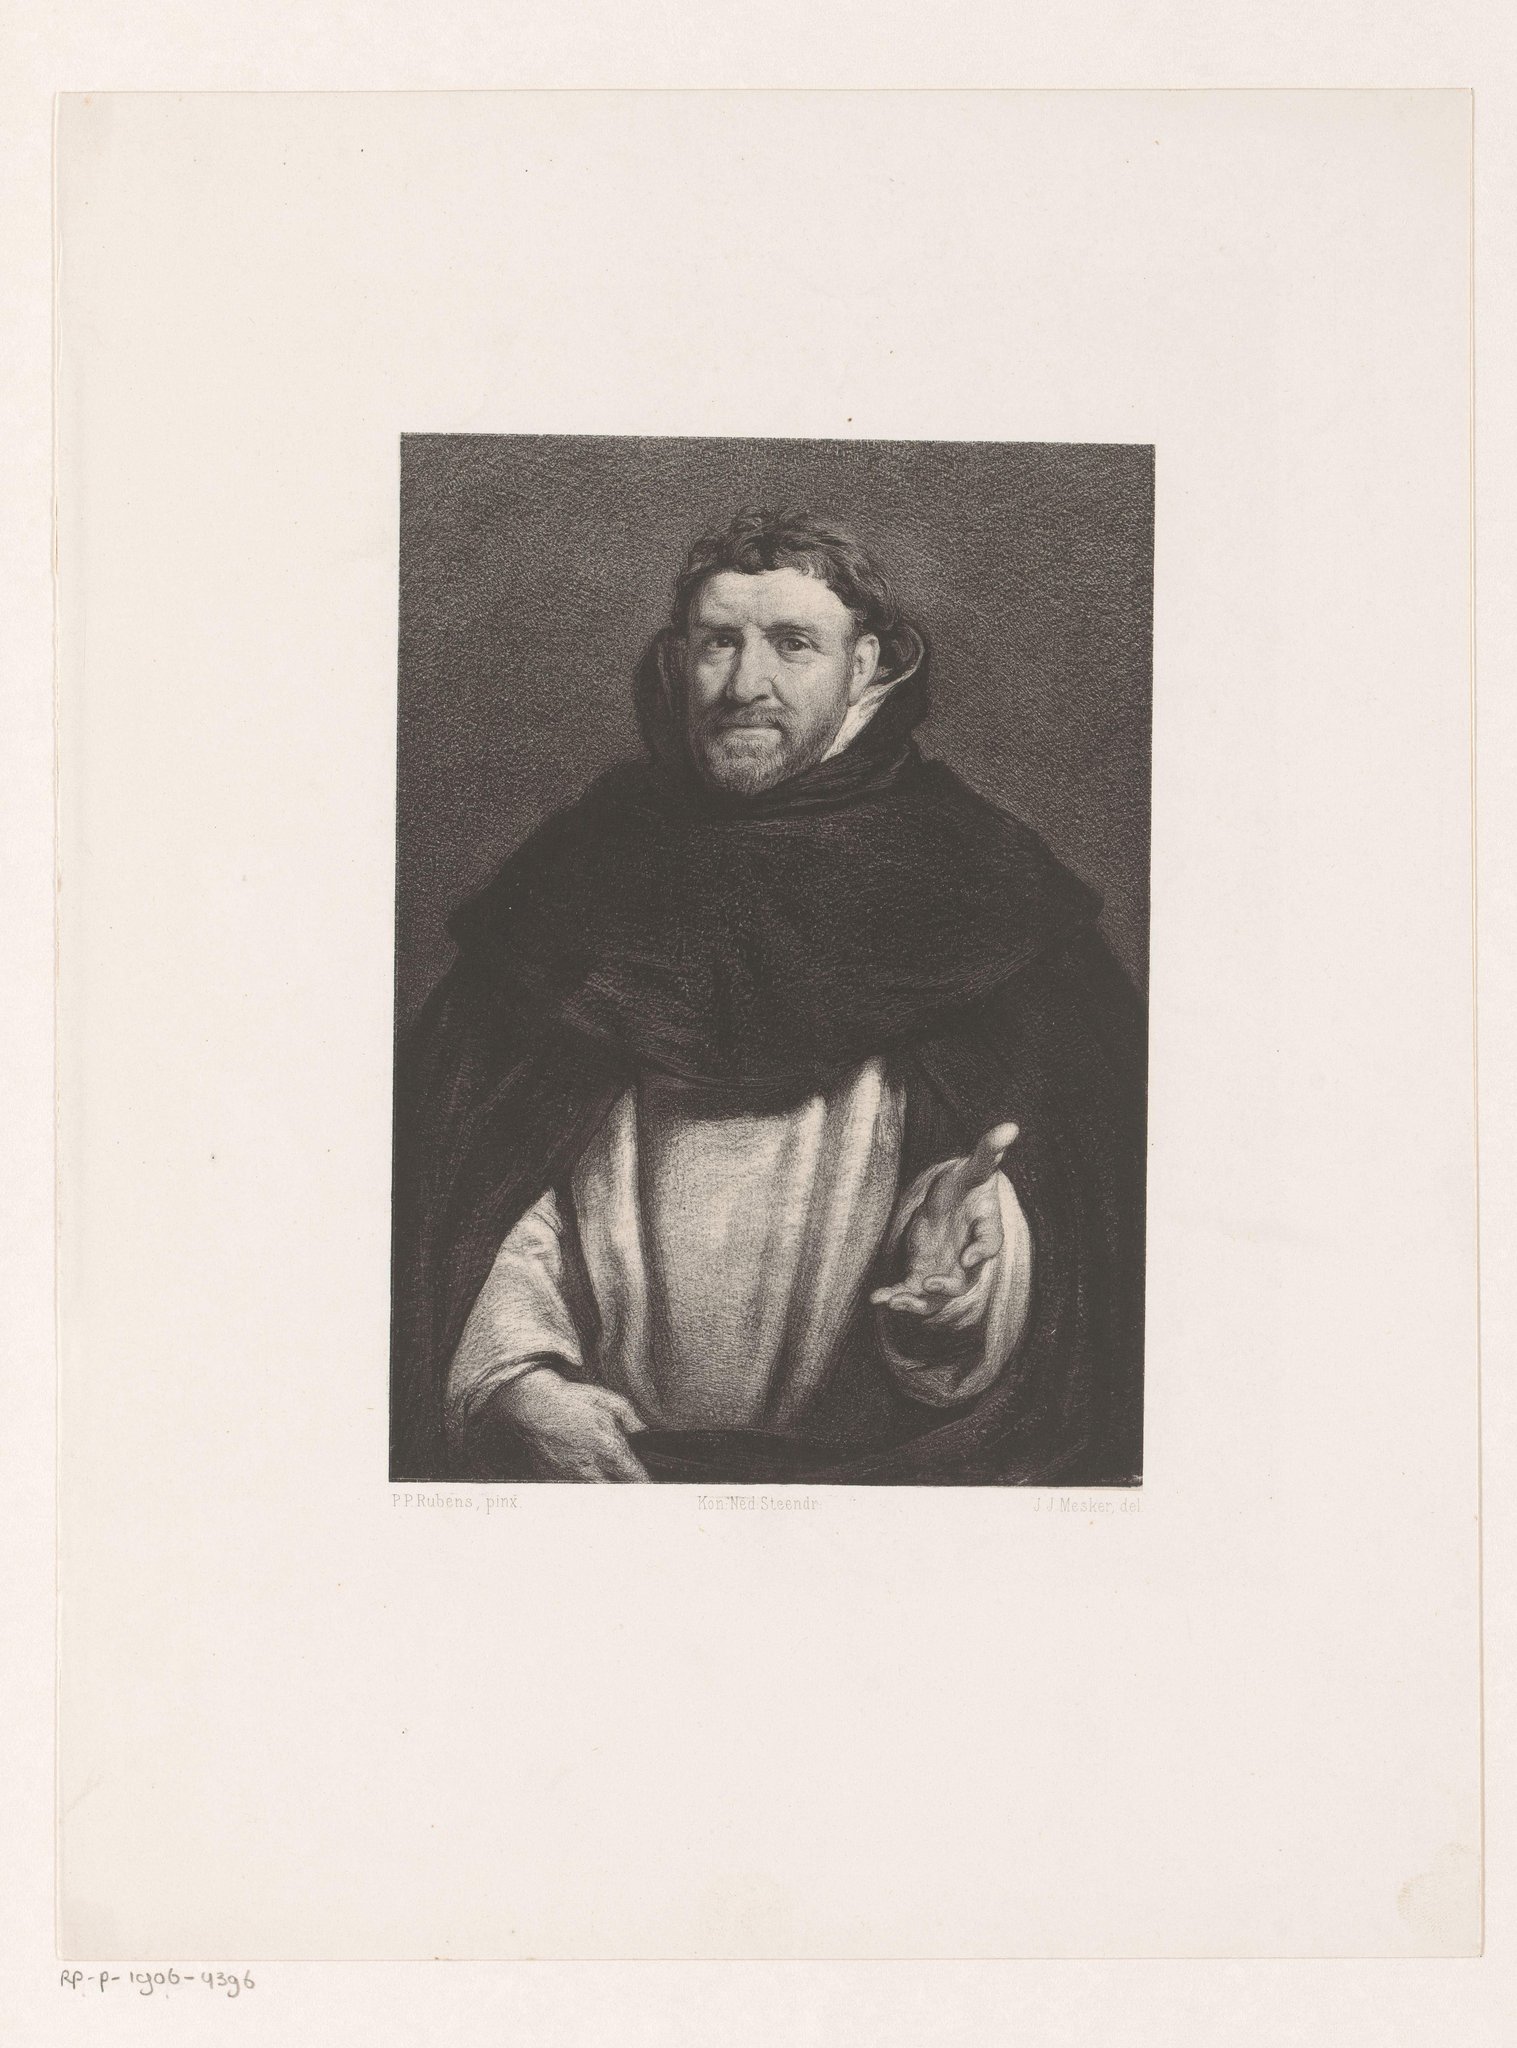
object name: print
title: Portret van bisschop Michiel Ophovius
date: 1867-1874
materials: paper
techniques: lithograph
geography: the hague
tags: den bosch, lierre, michael ophovius, monk(s), friar(s), historical persons (+ half-length portrait), monastic orders, monastic life: dominicans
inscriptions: collector's mark: Lugt 2228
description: De monnik draagt een habijt van de Dominicaner orde.